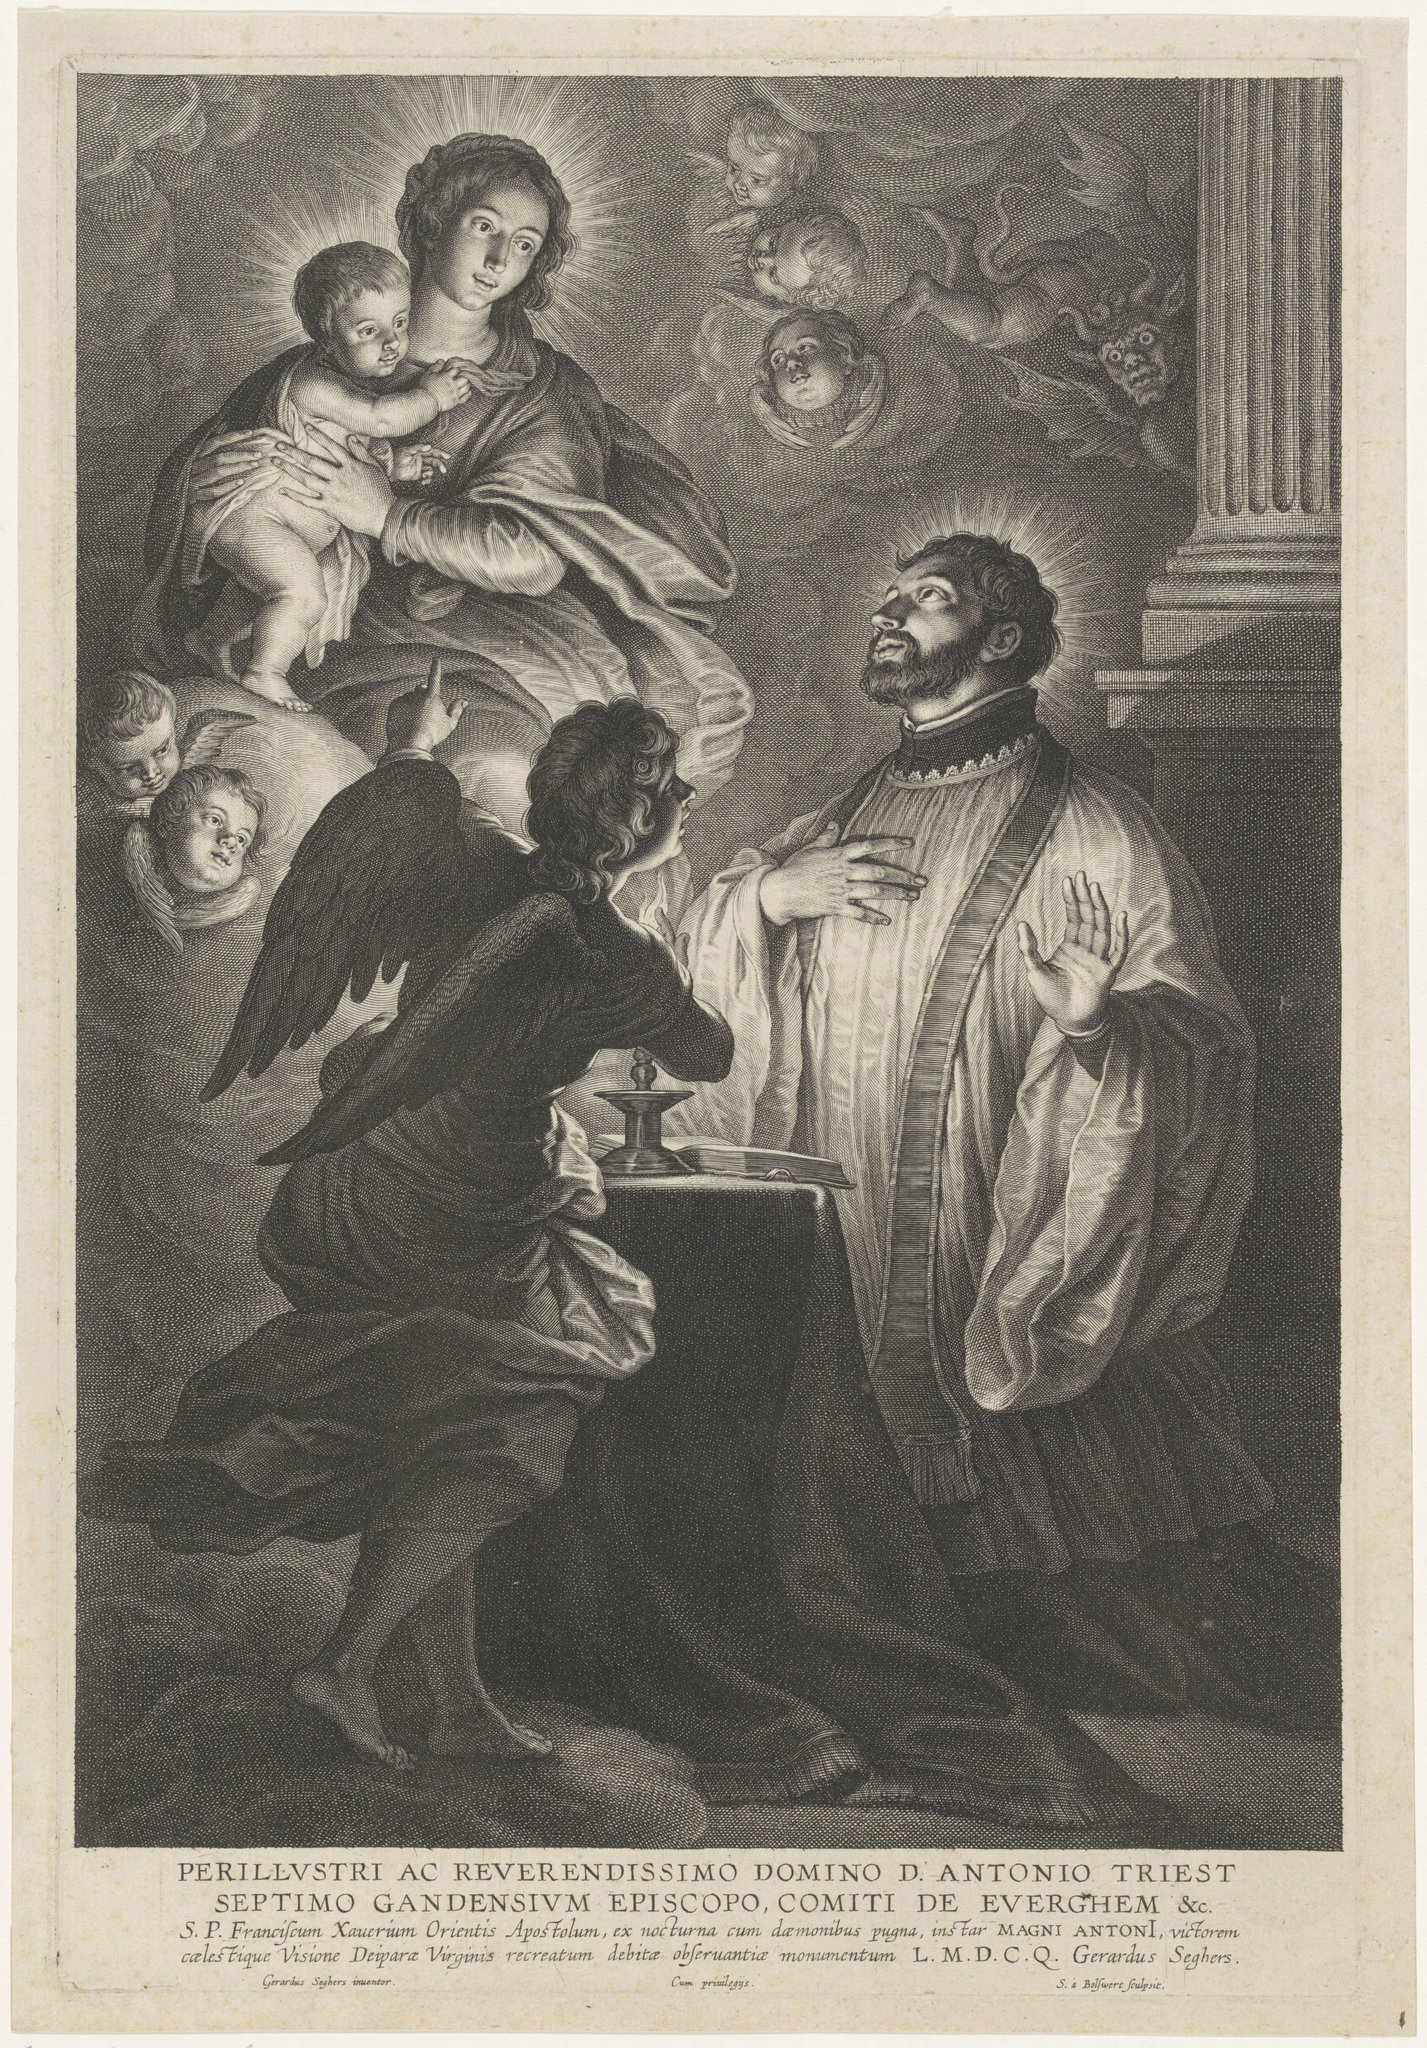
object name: print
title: Heilige Franciscus Xaverius aanbidt Maria met kind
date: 1596-1659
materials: paper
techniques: engraving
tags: madonna (i.e. mary with the christ-child) in the air, or on the clouds, the jesuit missionary francis xavier; possible attributes: cross, crucifix, flaming heart, indian, lily, torch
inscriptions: collector's mark: Lugt 11, number: ‘1’, collector's mark: Lugt 10